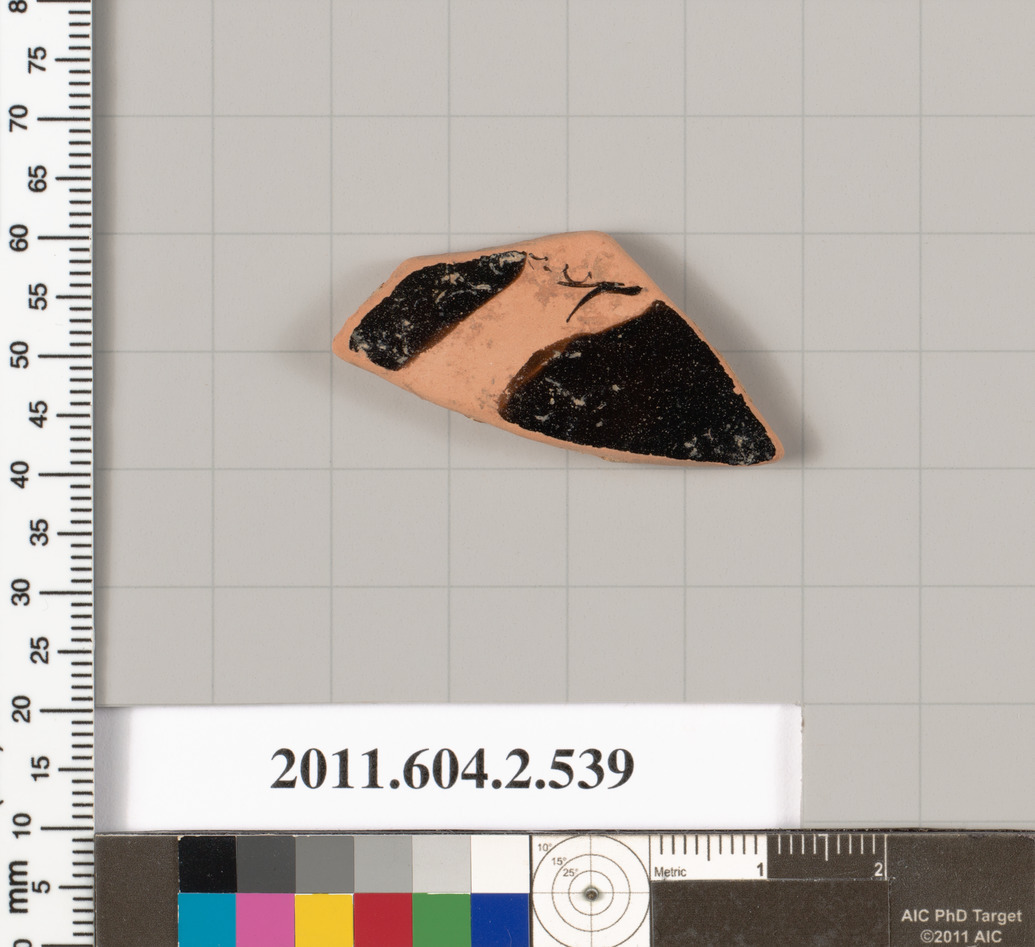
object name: column krater fragment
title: Terracotta fragment of a column-krater (bowl for mixing wine and water)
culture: greek, attic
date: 460-440 BCE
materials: terracotta